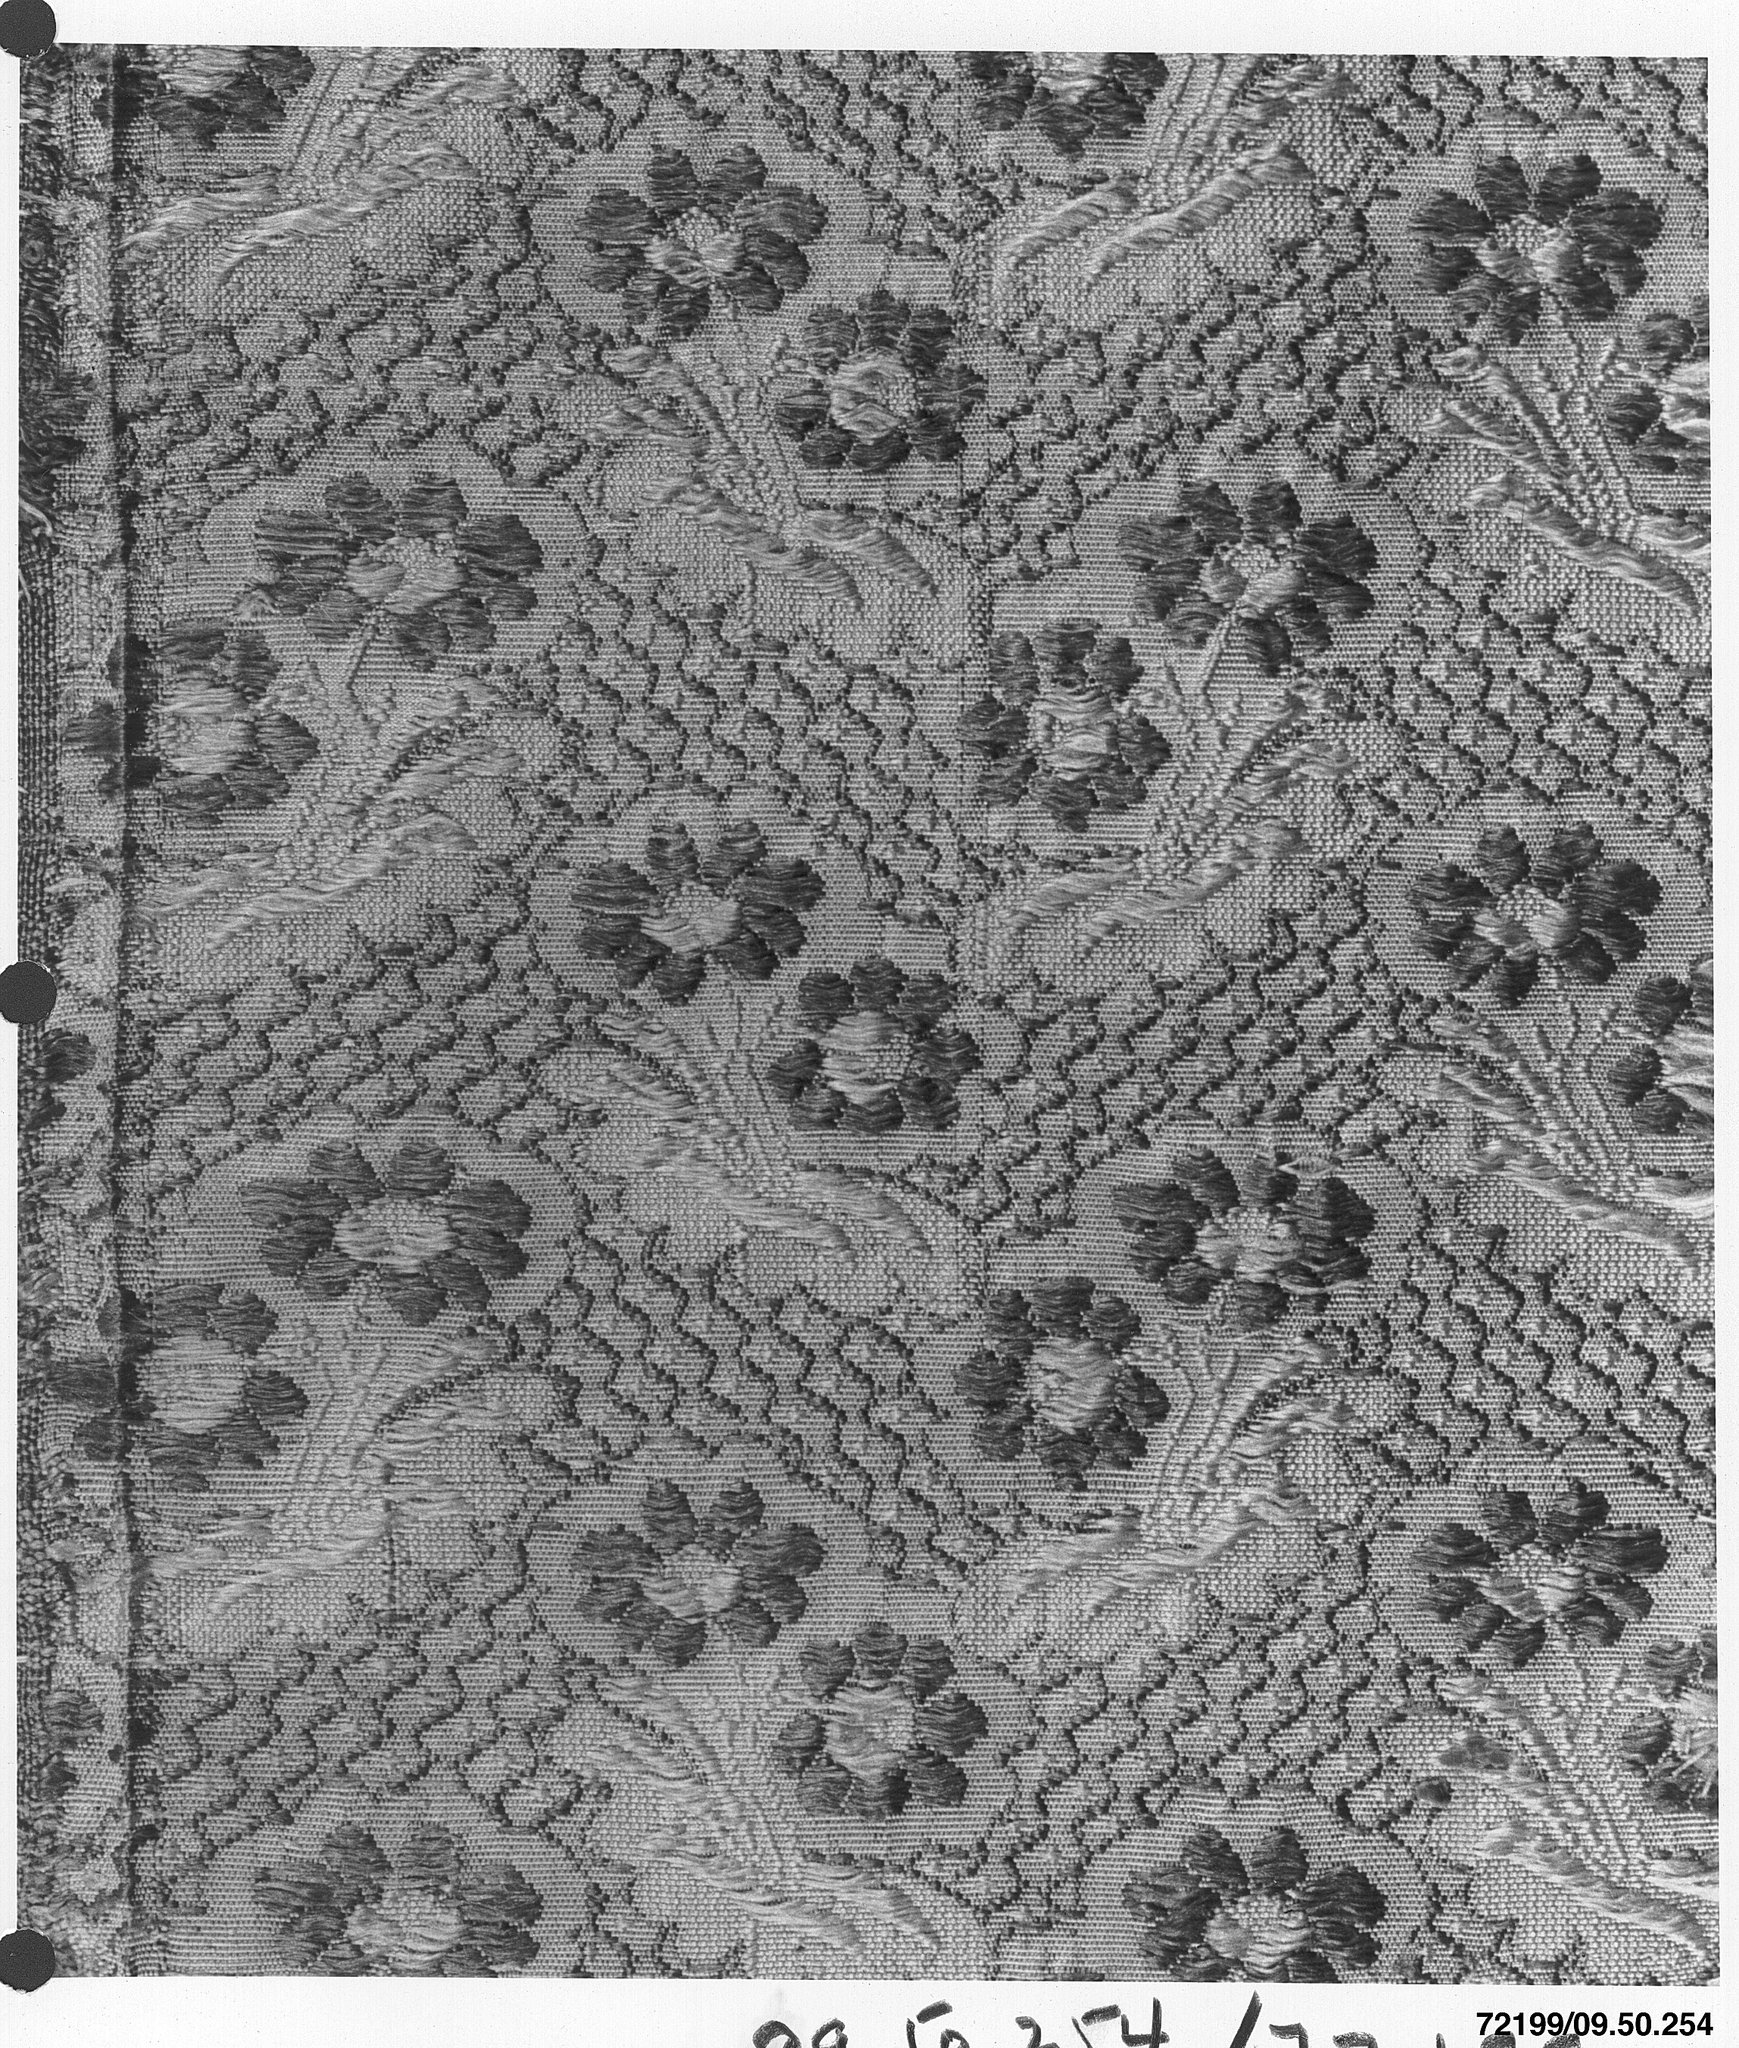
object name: piece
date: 1701-1800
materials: silk